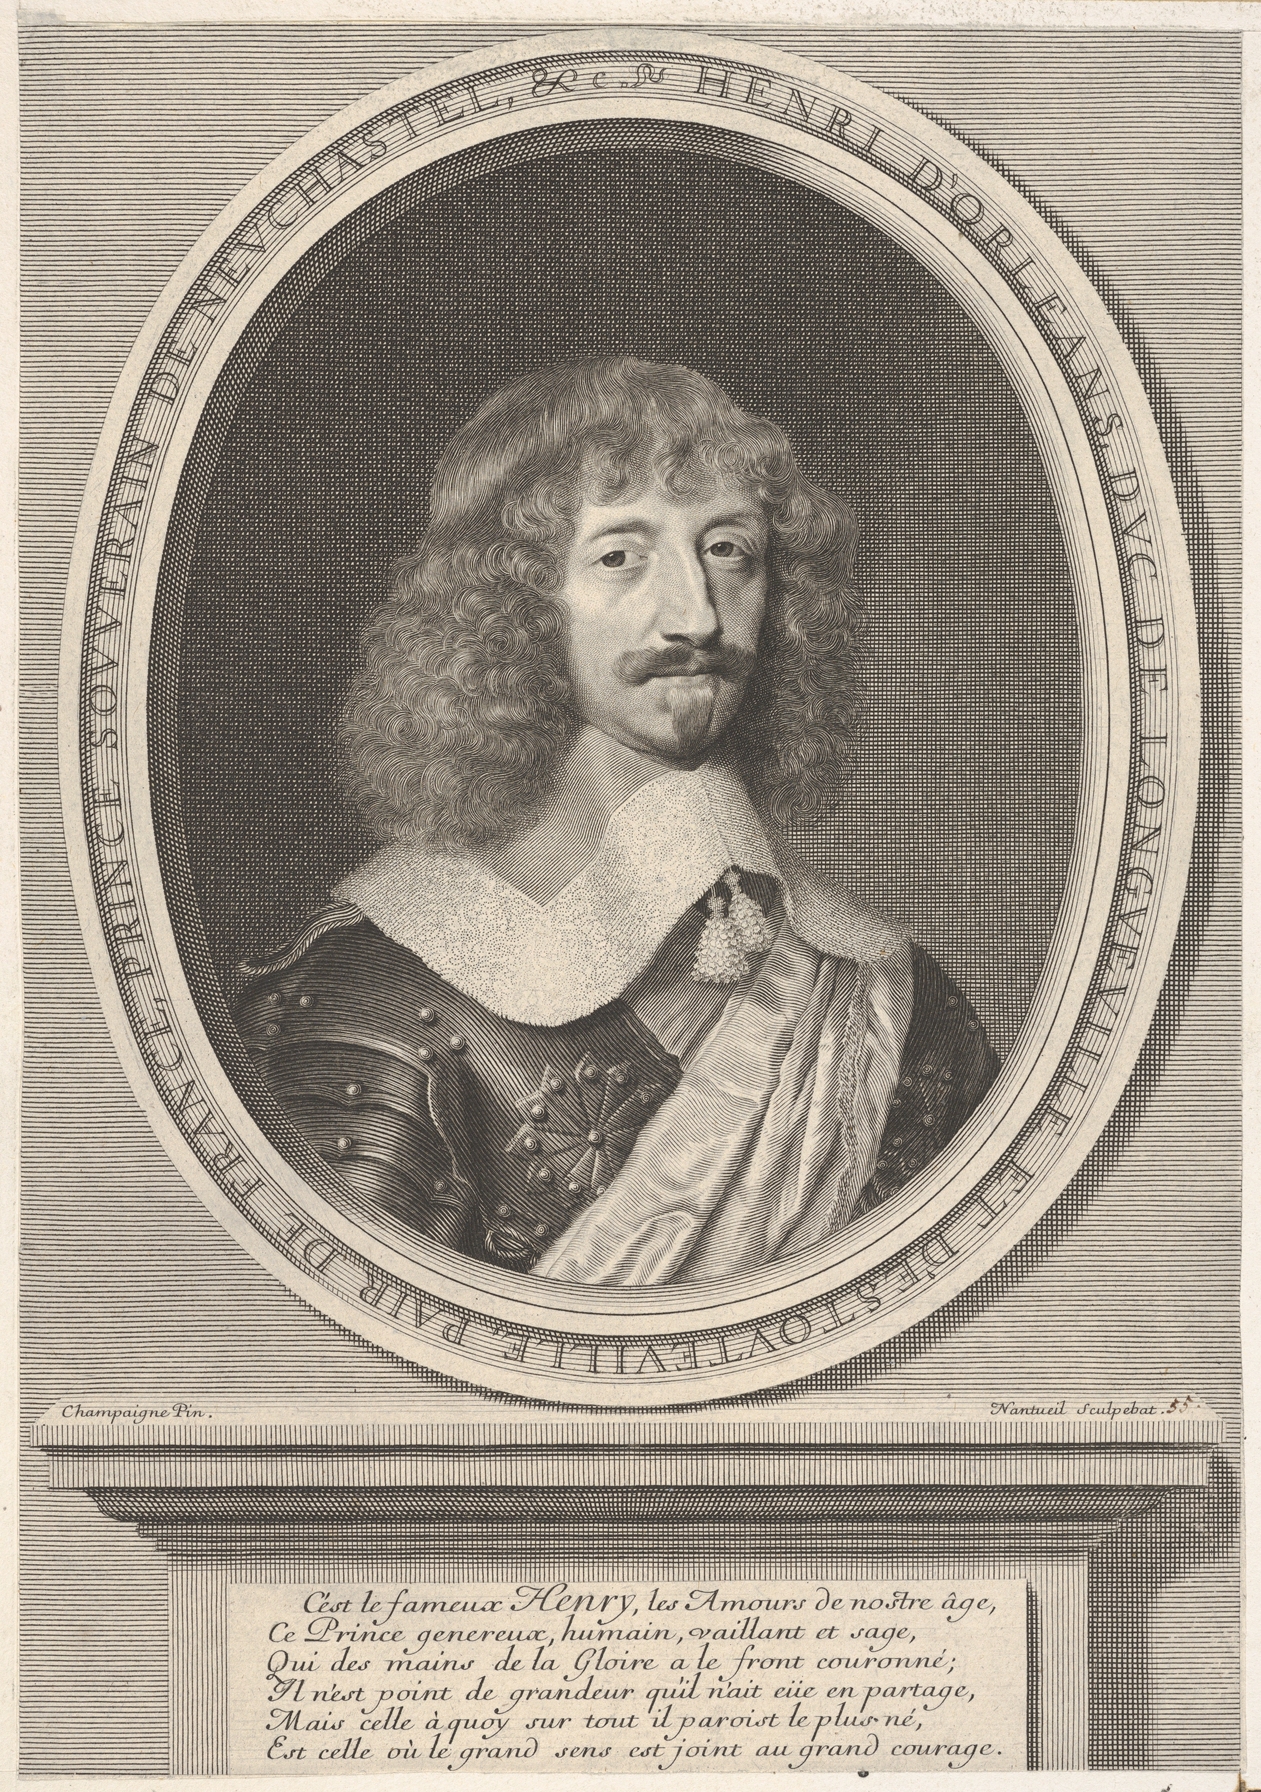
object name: print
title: Henri II d'Orléans, Duc de Longueville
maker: robert nanteuil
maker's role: artist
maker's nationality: french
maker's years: 1623-1678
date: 1655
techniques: engraving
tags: men,portraits